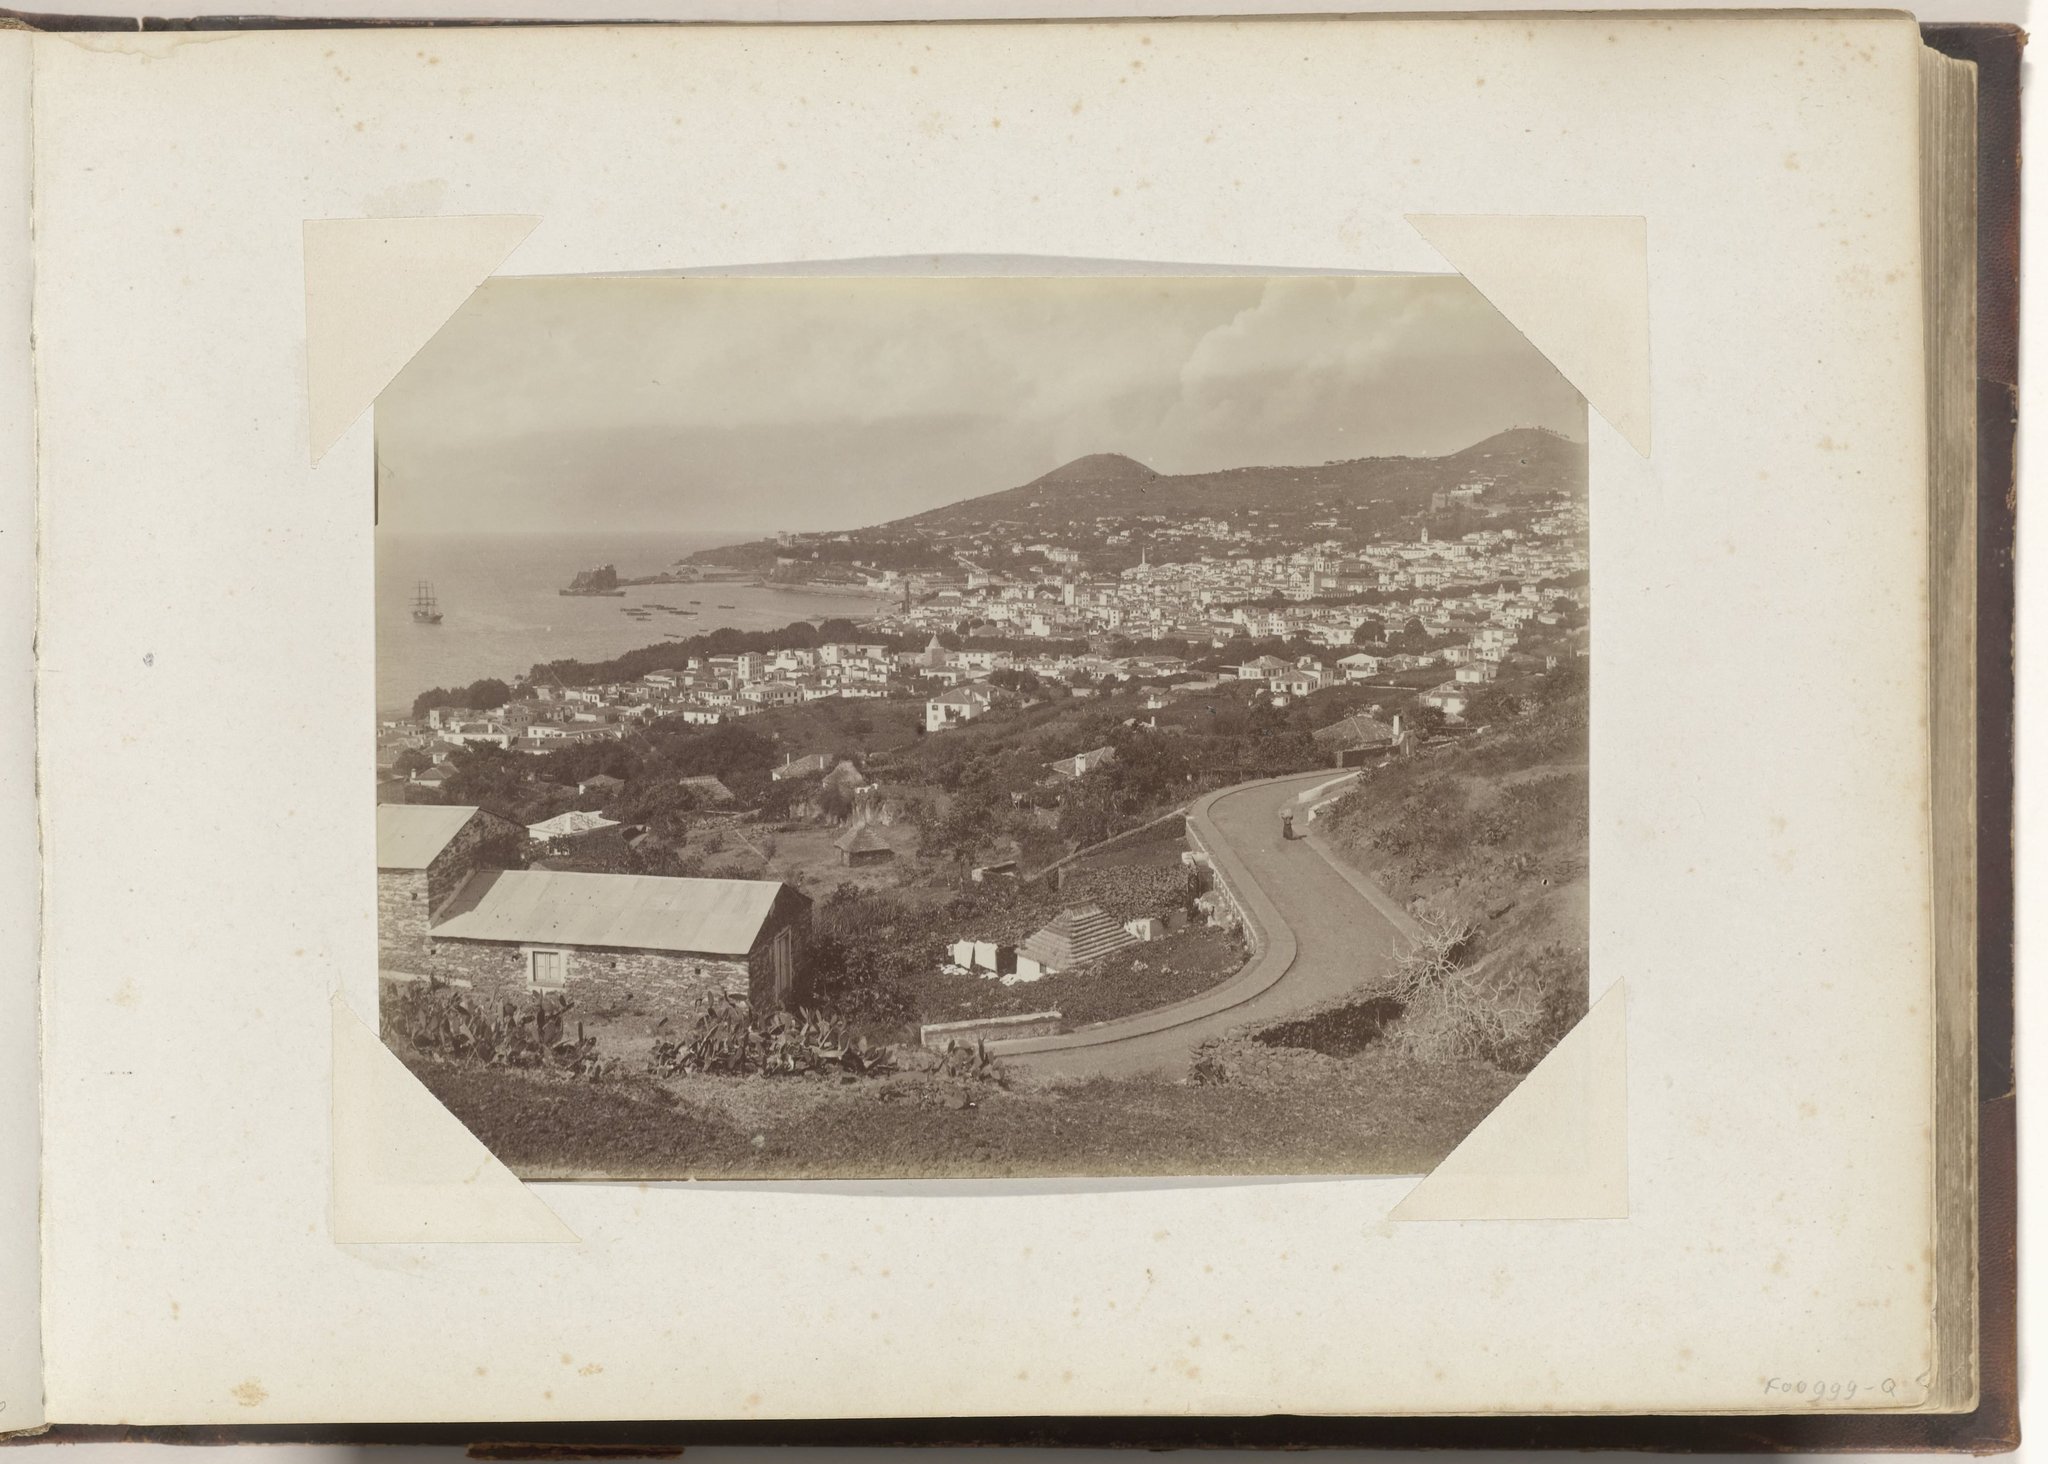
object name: photograph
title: Gezicht op Carvalhal Street en een baai met schepen in Funchal (Madeira)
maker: Anonymous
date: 1885-1910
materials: paper, photographic support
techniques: albumen print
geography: funchal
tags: prospect of city, town panorama, silhouette of city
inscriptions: inscription: ‘Carvalhal Street Madeira’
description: Onderdeel van Album met 191 foto's van een reis naar en door Zuid-Afrika.